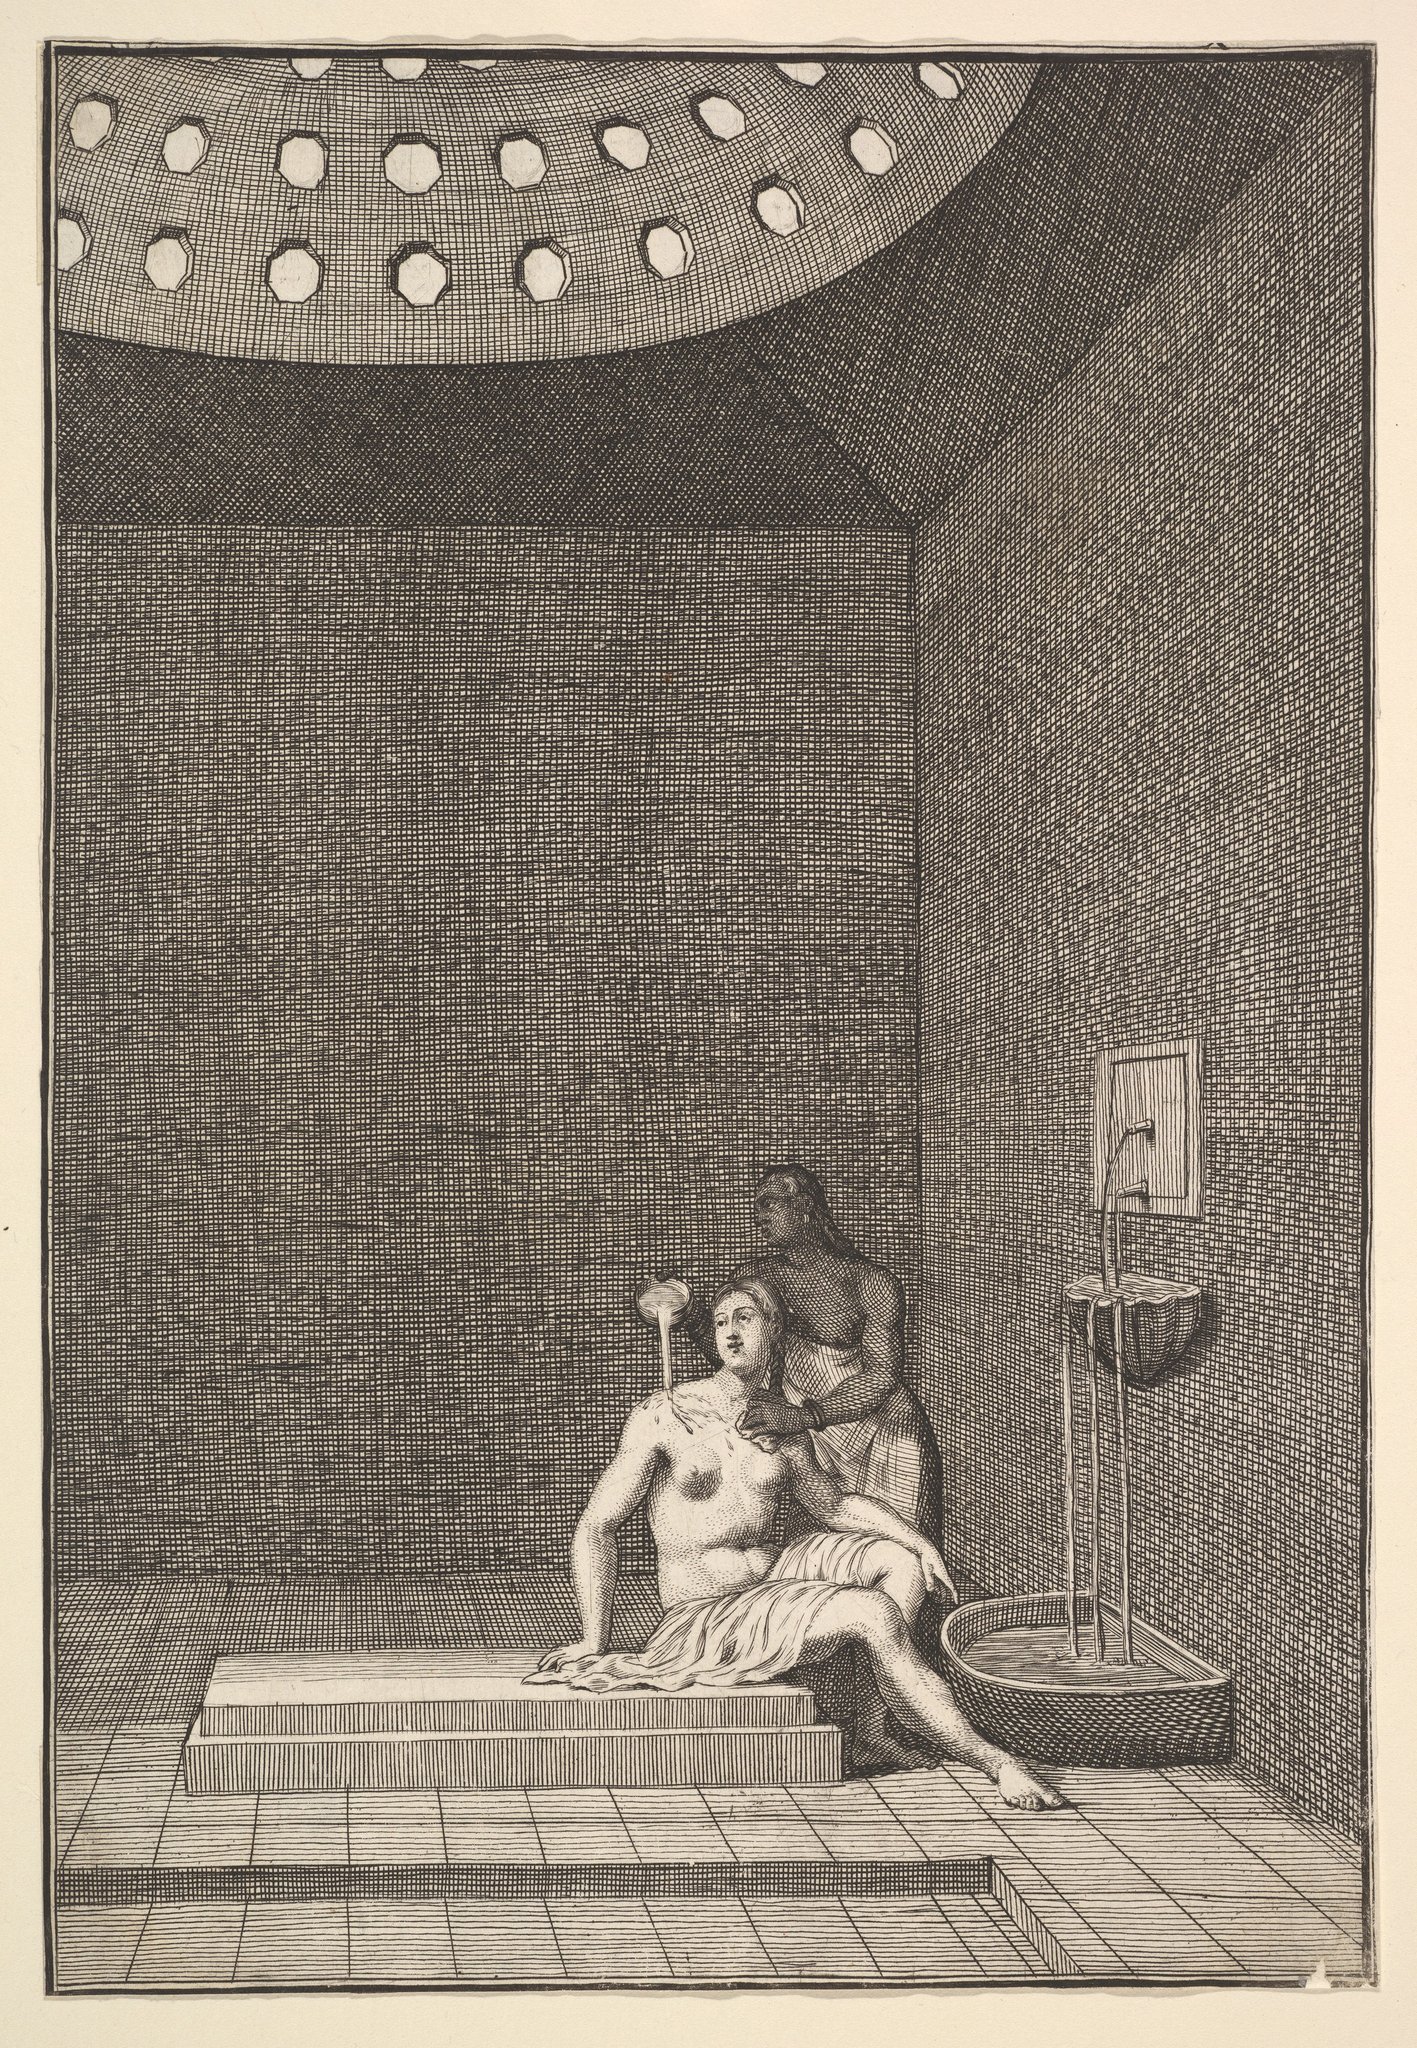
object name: print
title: A Turkish Bath (Aubry de La Mottraye's "Travels throughout Europe, Asia and into Part of Africa...," London, 1724, vol. I, pl. 10)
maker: william hogarth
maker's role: artist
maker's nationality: british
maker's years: 1697-1764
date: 1723-1724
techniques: engraving, etching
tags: men,female nudes,bathing